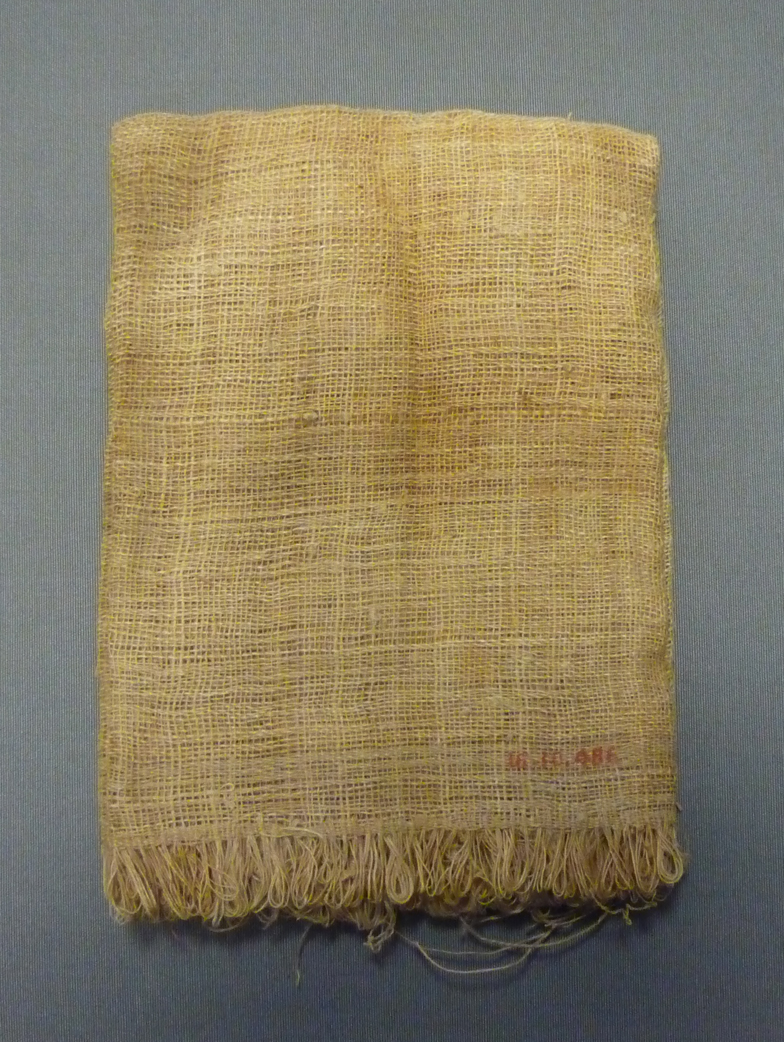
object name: linen ritual cloth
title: Miniature Linen Sheet From Foundation Deposit 2 of Hatshepsut's Valley Temple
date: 1479-1458 BCE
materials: linen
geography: egypt